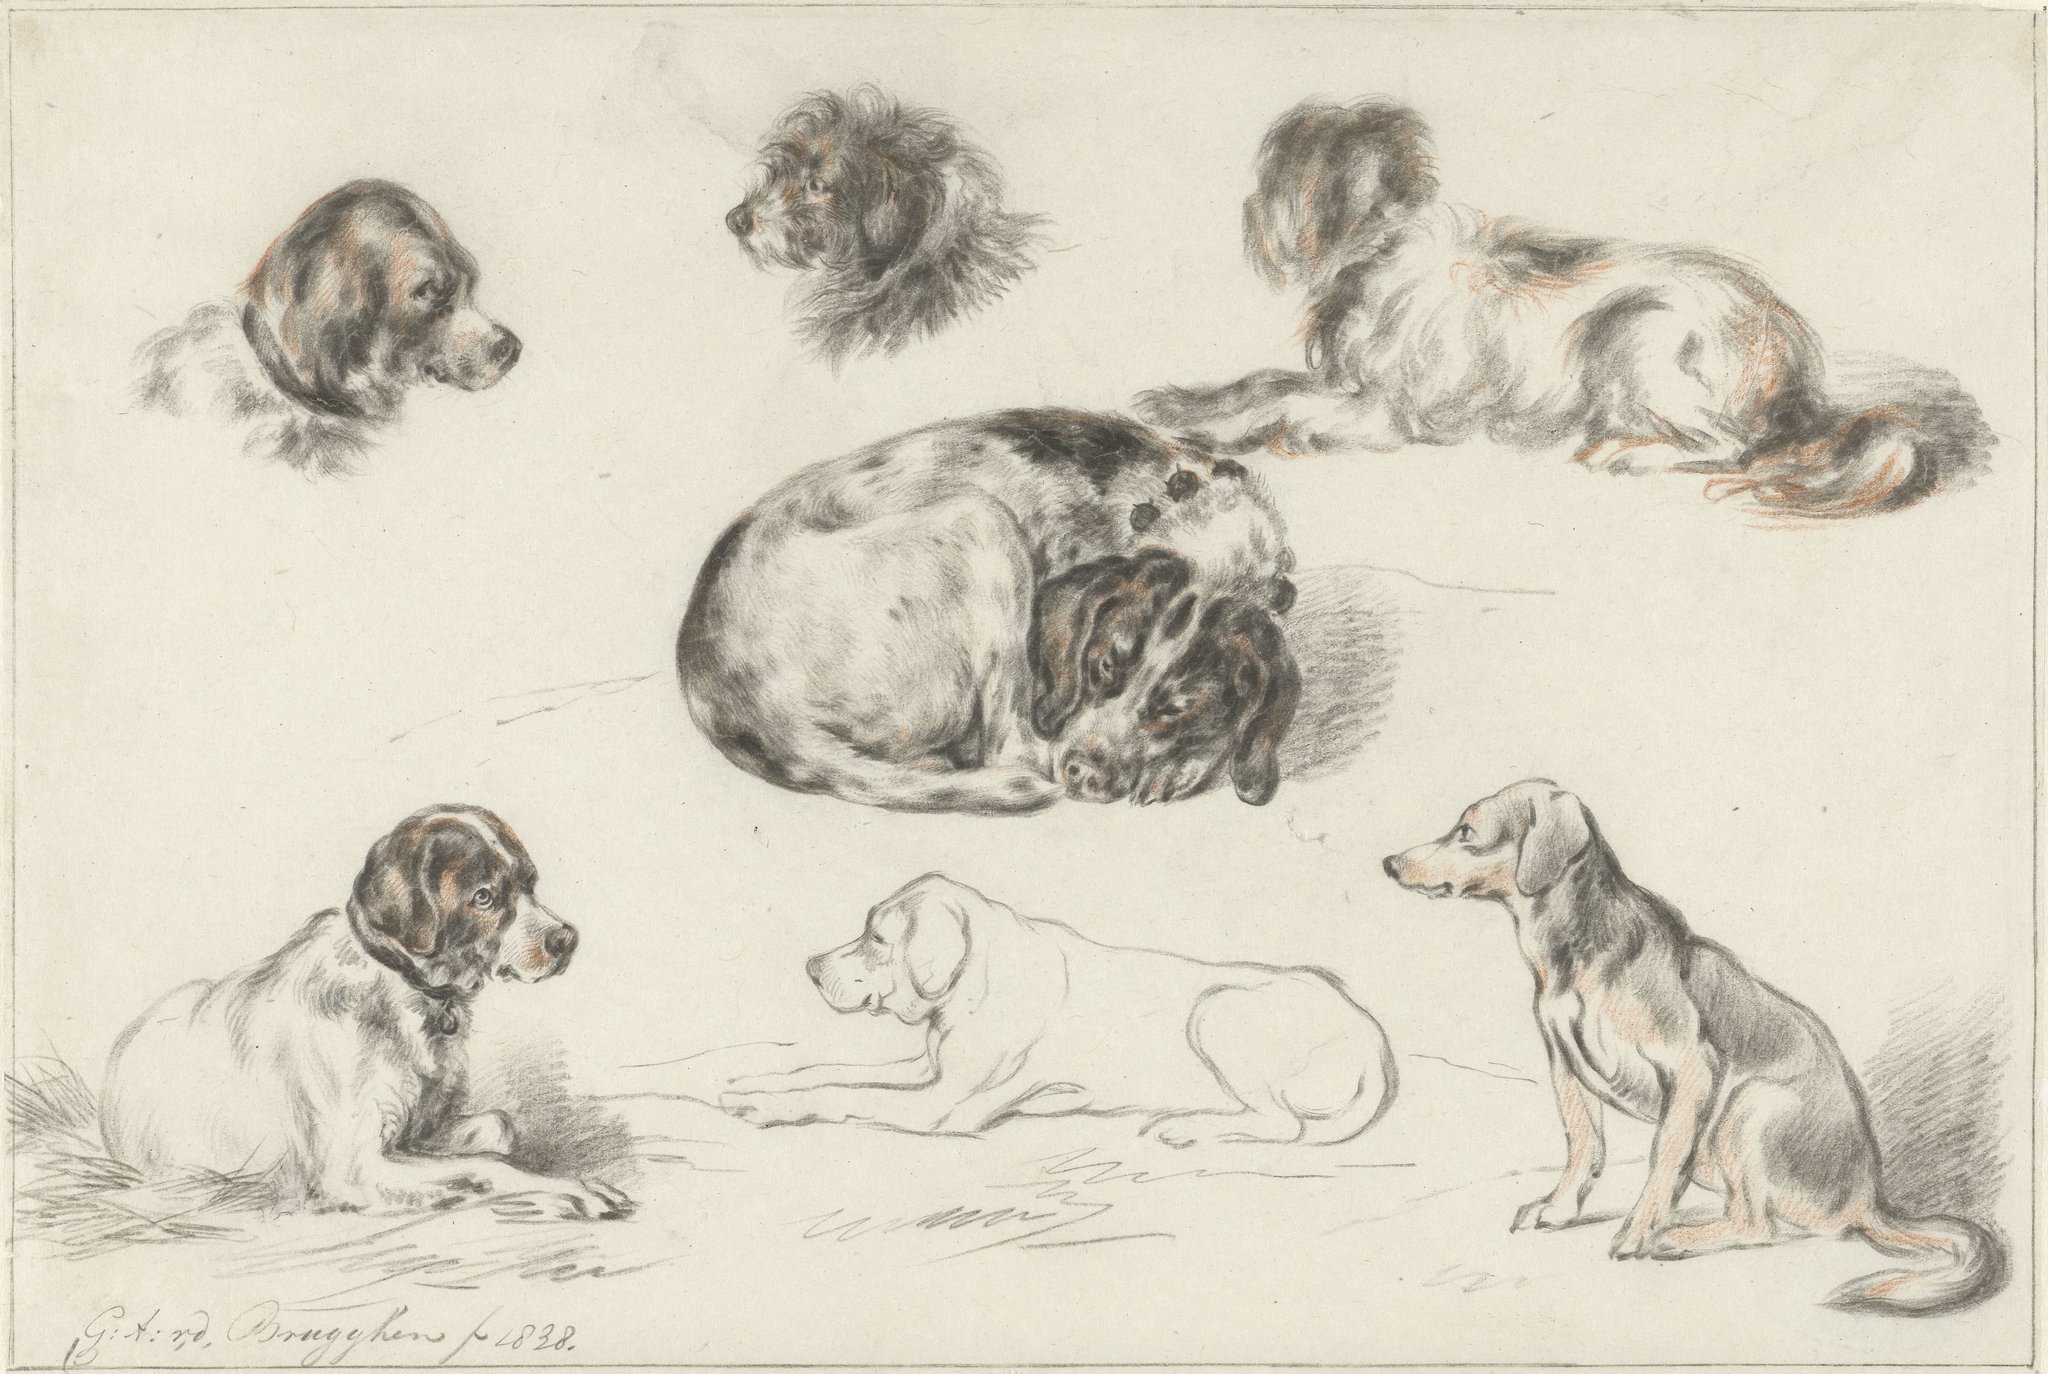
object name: drawing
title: Studies of Dogs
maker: guillaume anne van der brugghen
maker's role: draughtsman, print maker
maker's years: 1812-1891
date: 1838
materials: chalk, paper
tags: dog